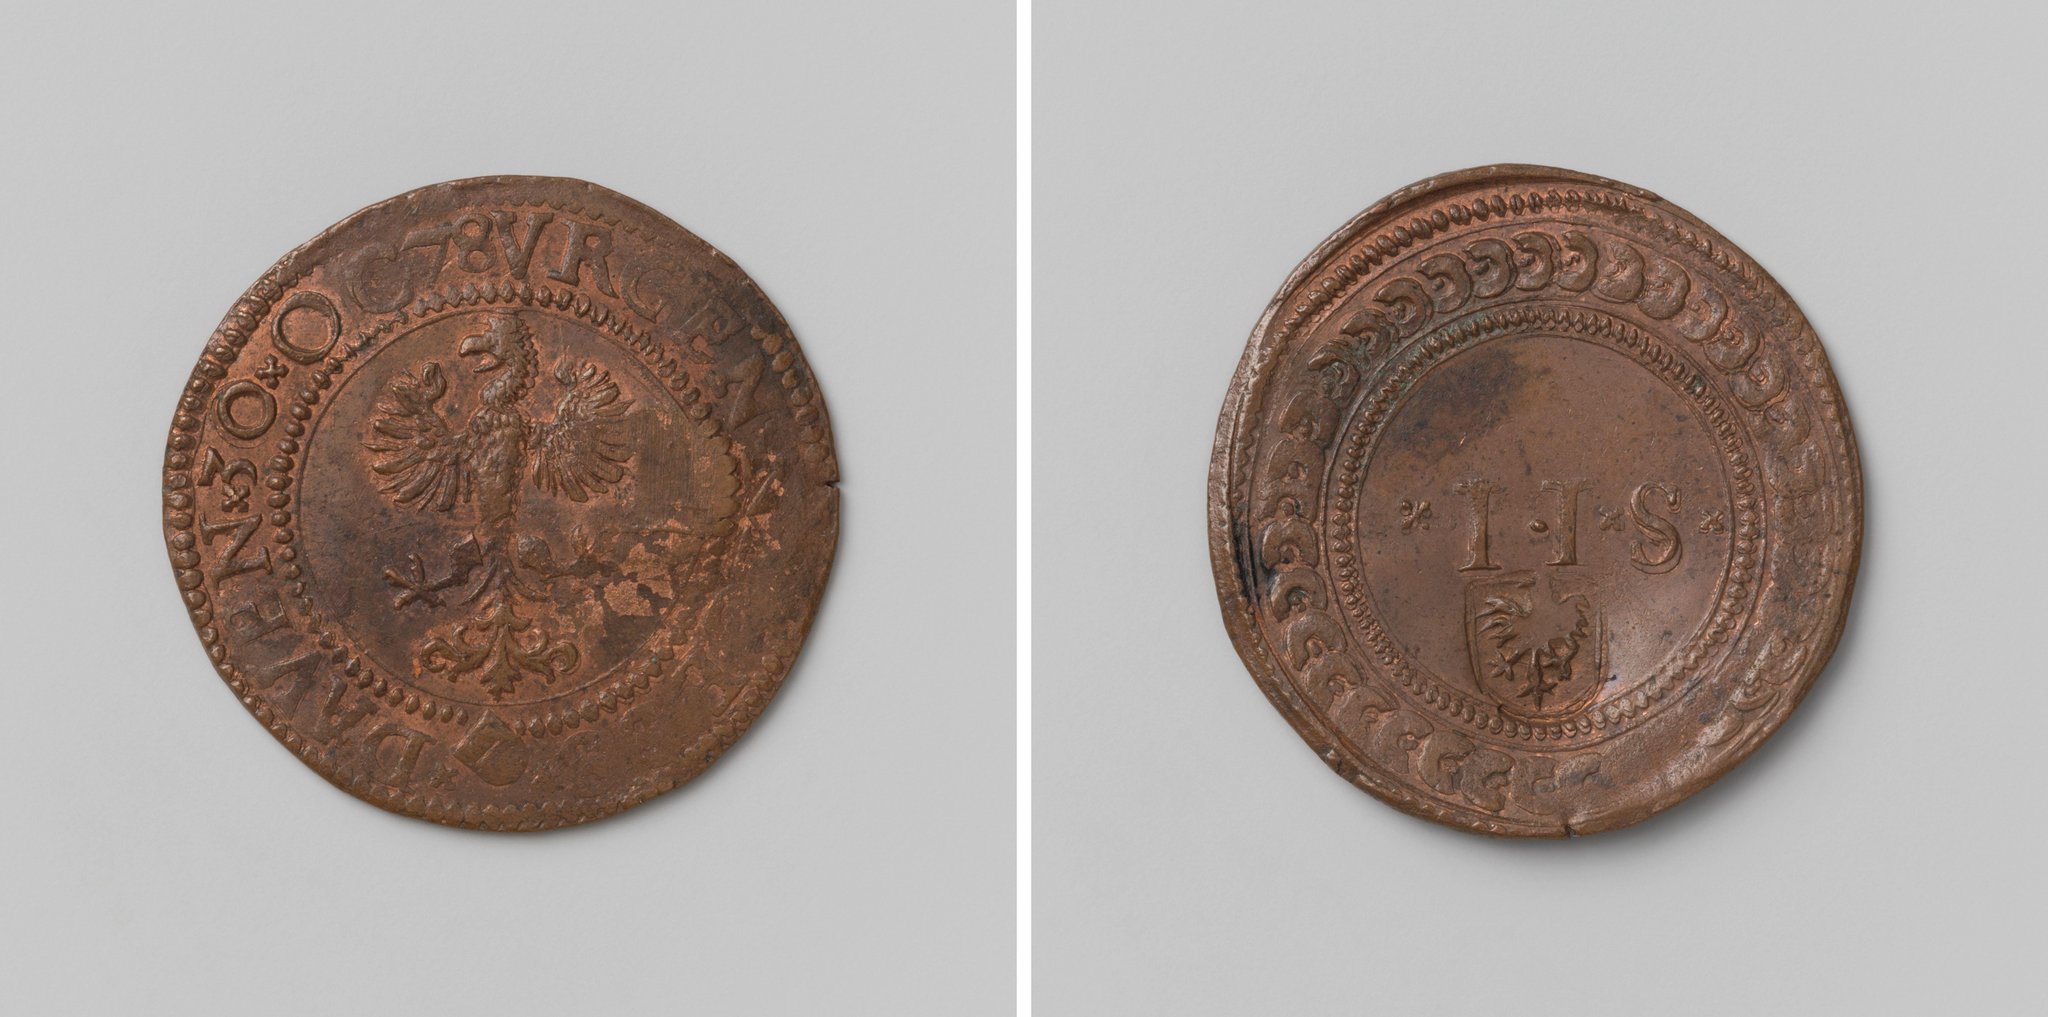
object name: siege coin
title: Twee stuiver, noodmunt uit Deventer, geslagen tijdens het beleg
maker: balthasar wijntgens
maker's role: mintmaster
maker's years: 1577-1592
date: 1578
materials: copper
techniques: striking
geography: deventer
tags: deventer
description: Voorzijde: gekroonde adelaar binnen omschrift. Keerzijde: Romeinse cijfer II en letter S binnen krans; klop: stadswapen